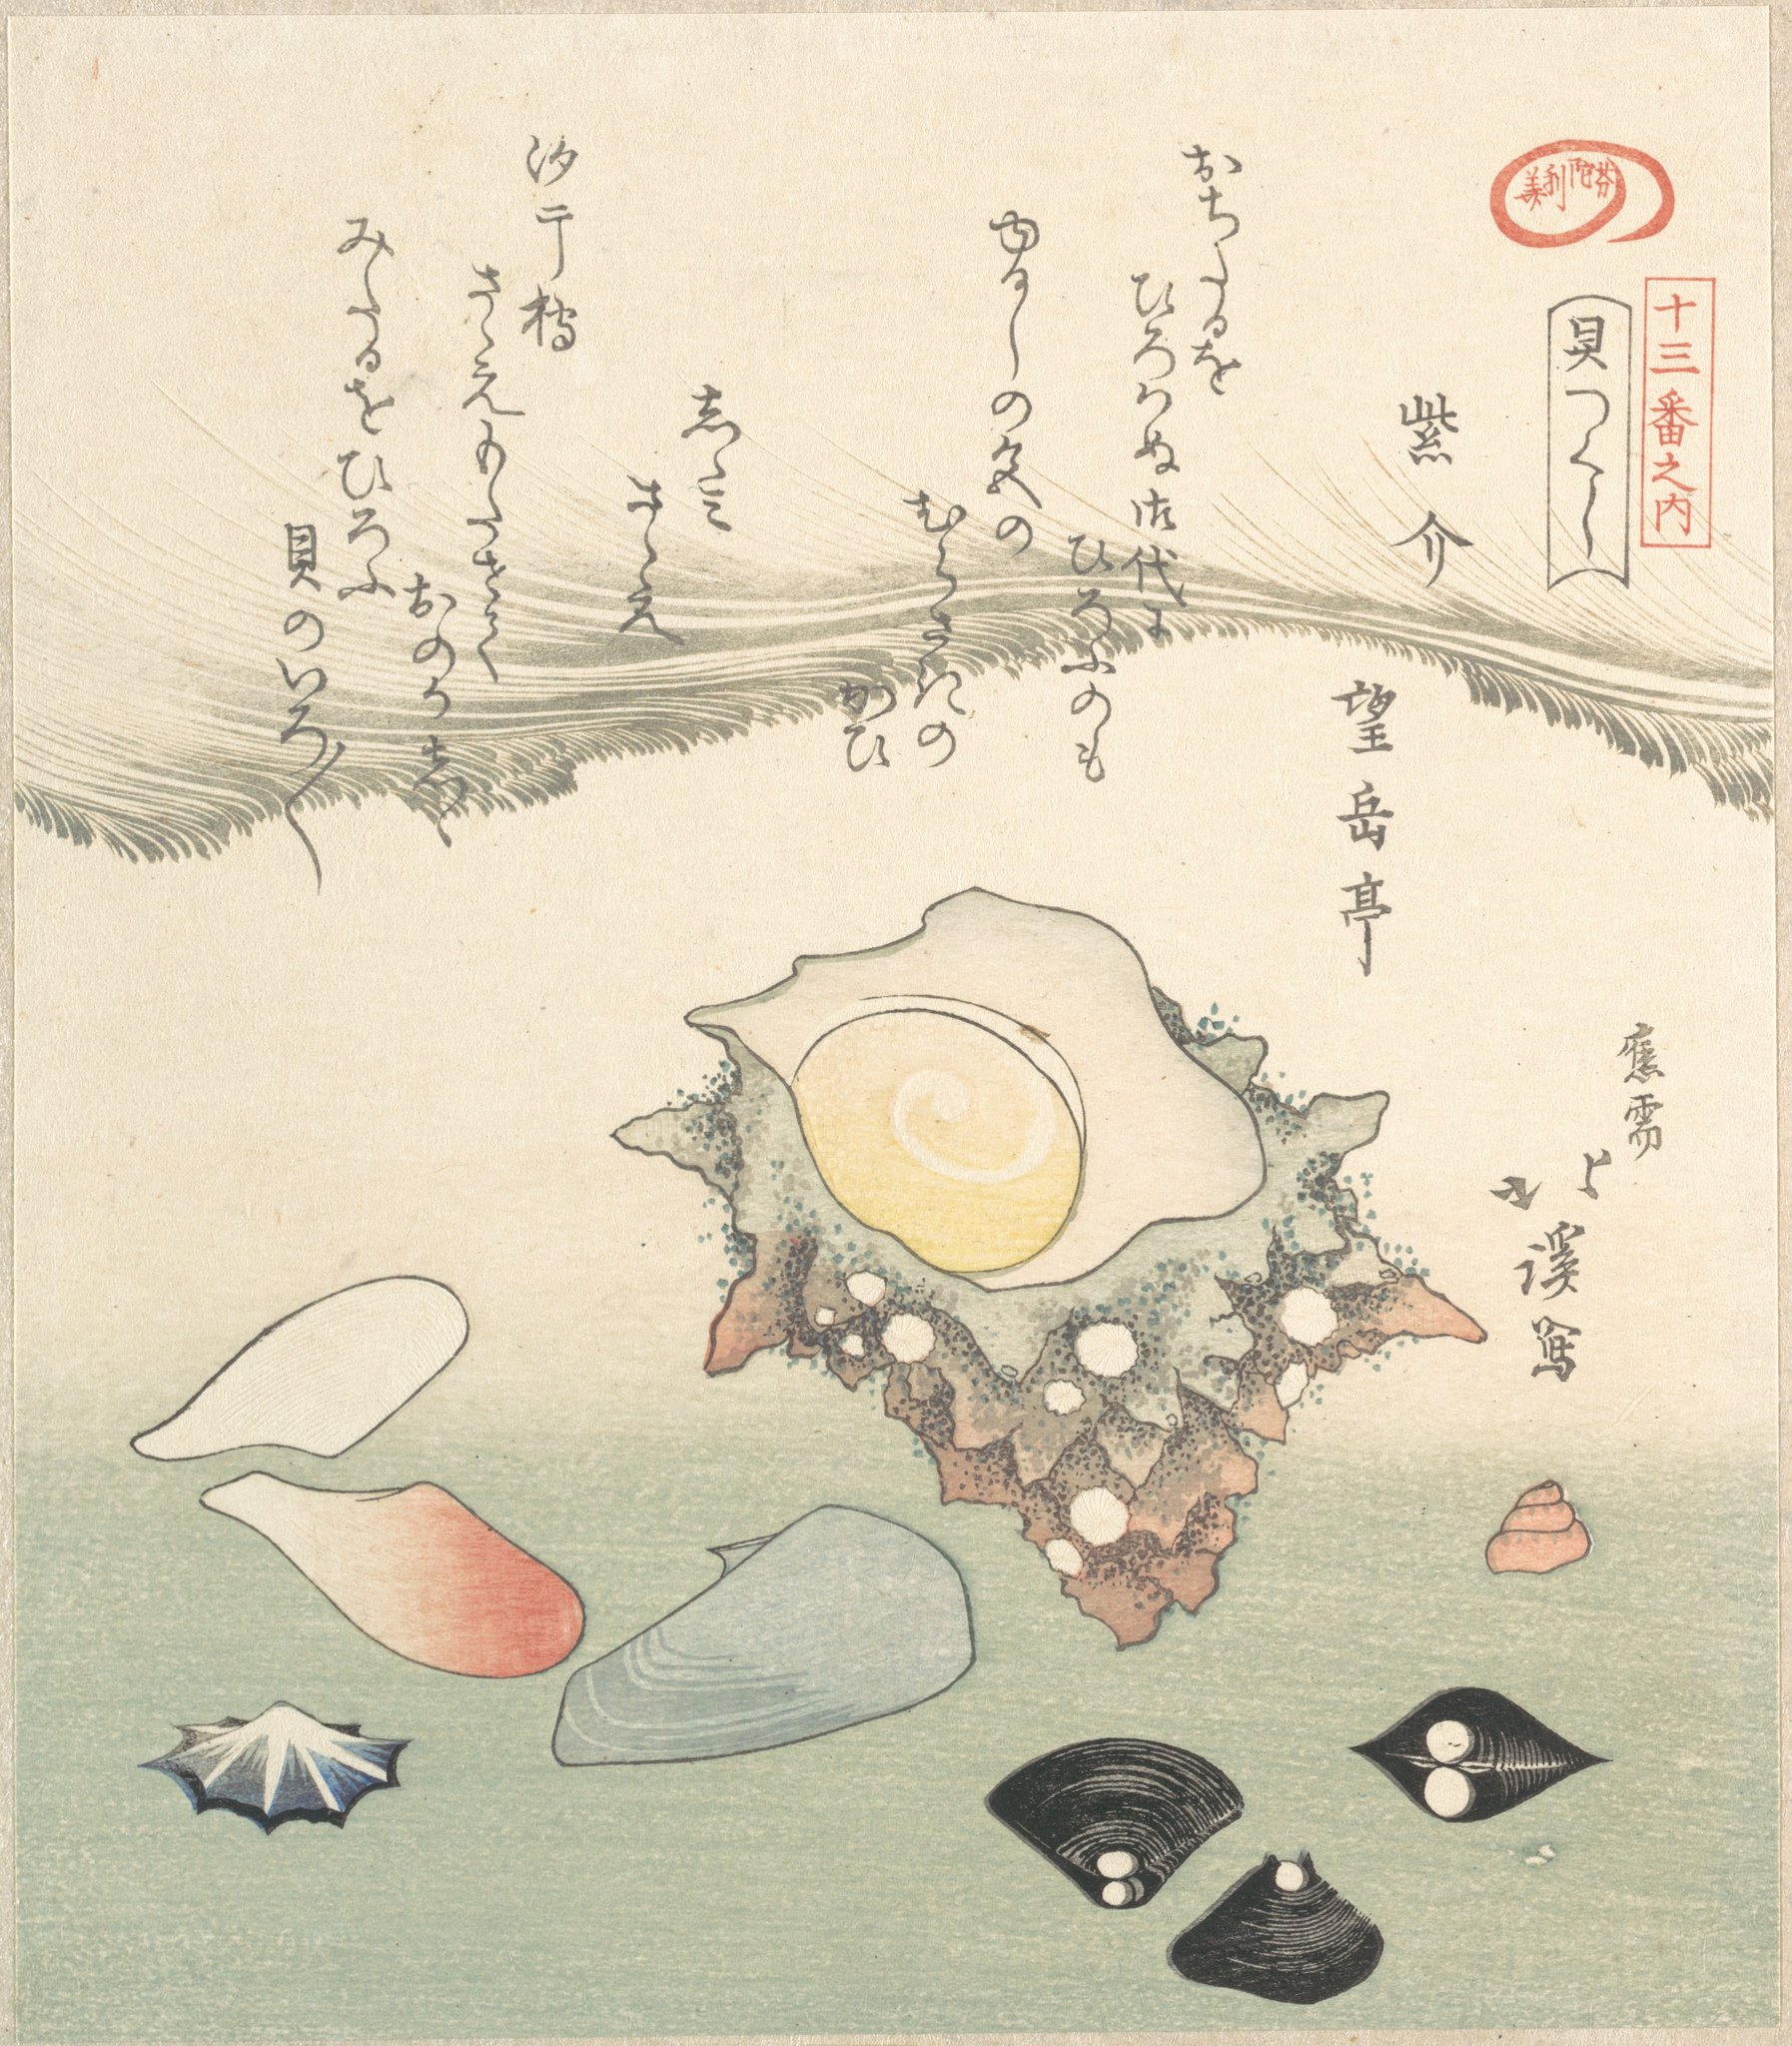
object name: print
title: Top-Shell and Various Shells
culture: japanese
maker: totoya hokkei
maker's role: artist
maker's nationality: japanese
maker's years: 1780-1850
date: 1801-1900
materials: ink, paper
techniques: surimono, woodblock print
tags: shells